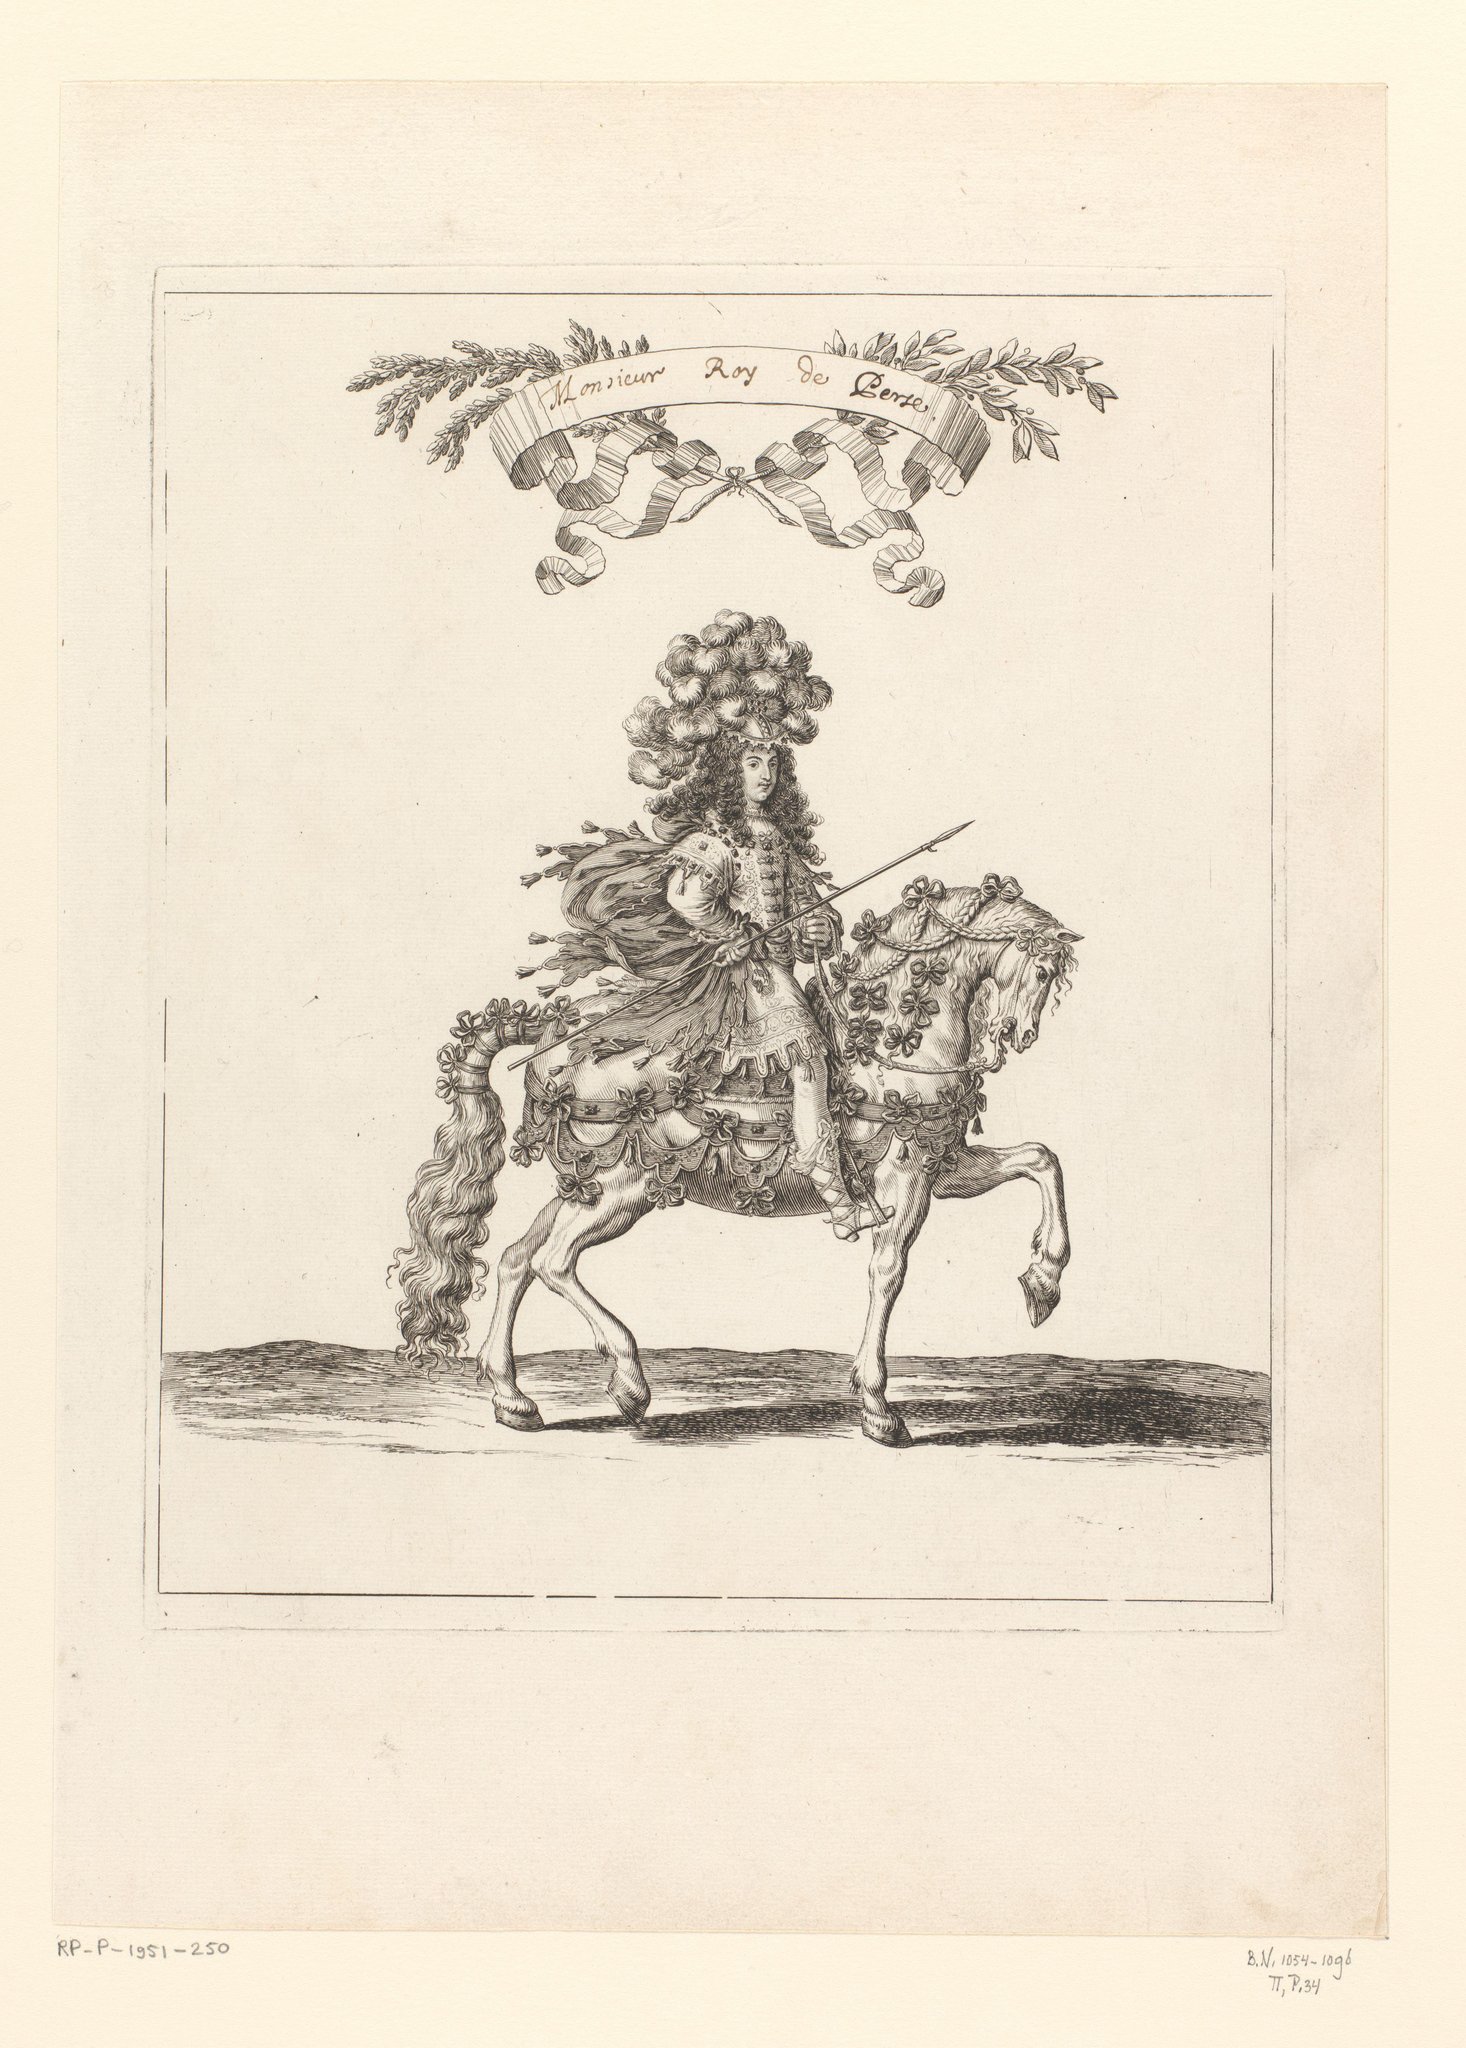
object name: print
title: Filips II, hertog van Orléans, te paard in Perzisch kostuum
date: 1670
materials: paper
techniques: etching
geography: france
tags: filips ii (hertog van orléans), tournament, historical persons, horse, festivities, king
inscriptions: inscription, collector's mark: Lugt 2228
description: Prent uit: Perrault, Charles. Courses de testes et de bague faites par le Roy et par les princes et seigneurs de sa cour en l'année M.DC.LXII. Parijs: Imprimerie Royale, 1670. De prenten illustreren de door Lodewijk XIV georganiseerde festiviteiten in juni 1662 te Tuileries, zoals steekspelen met figuren in verschillende kostuums.